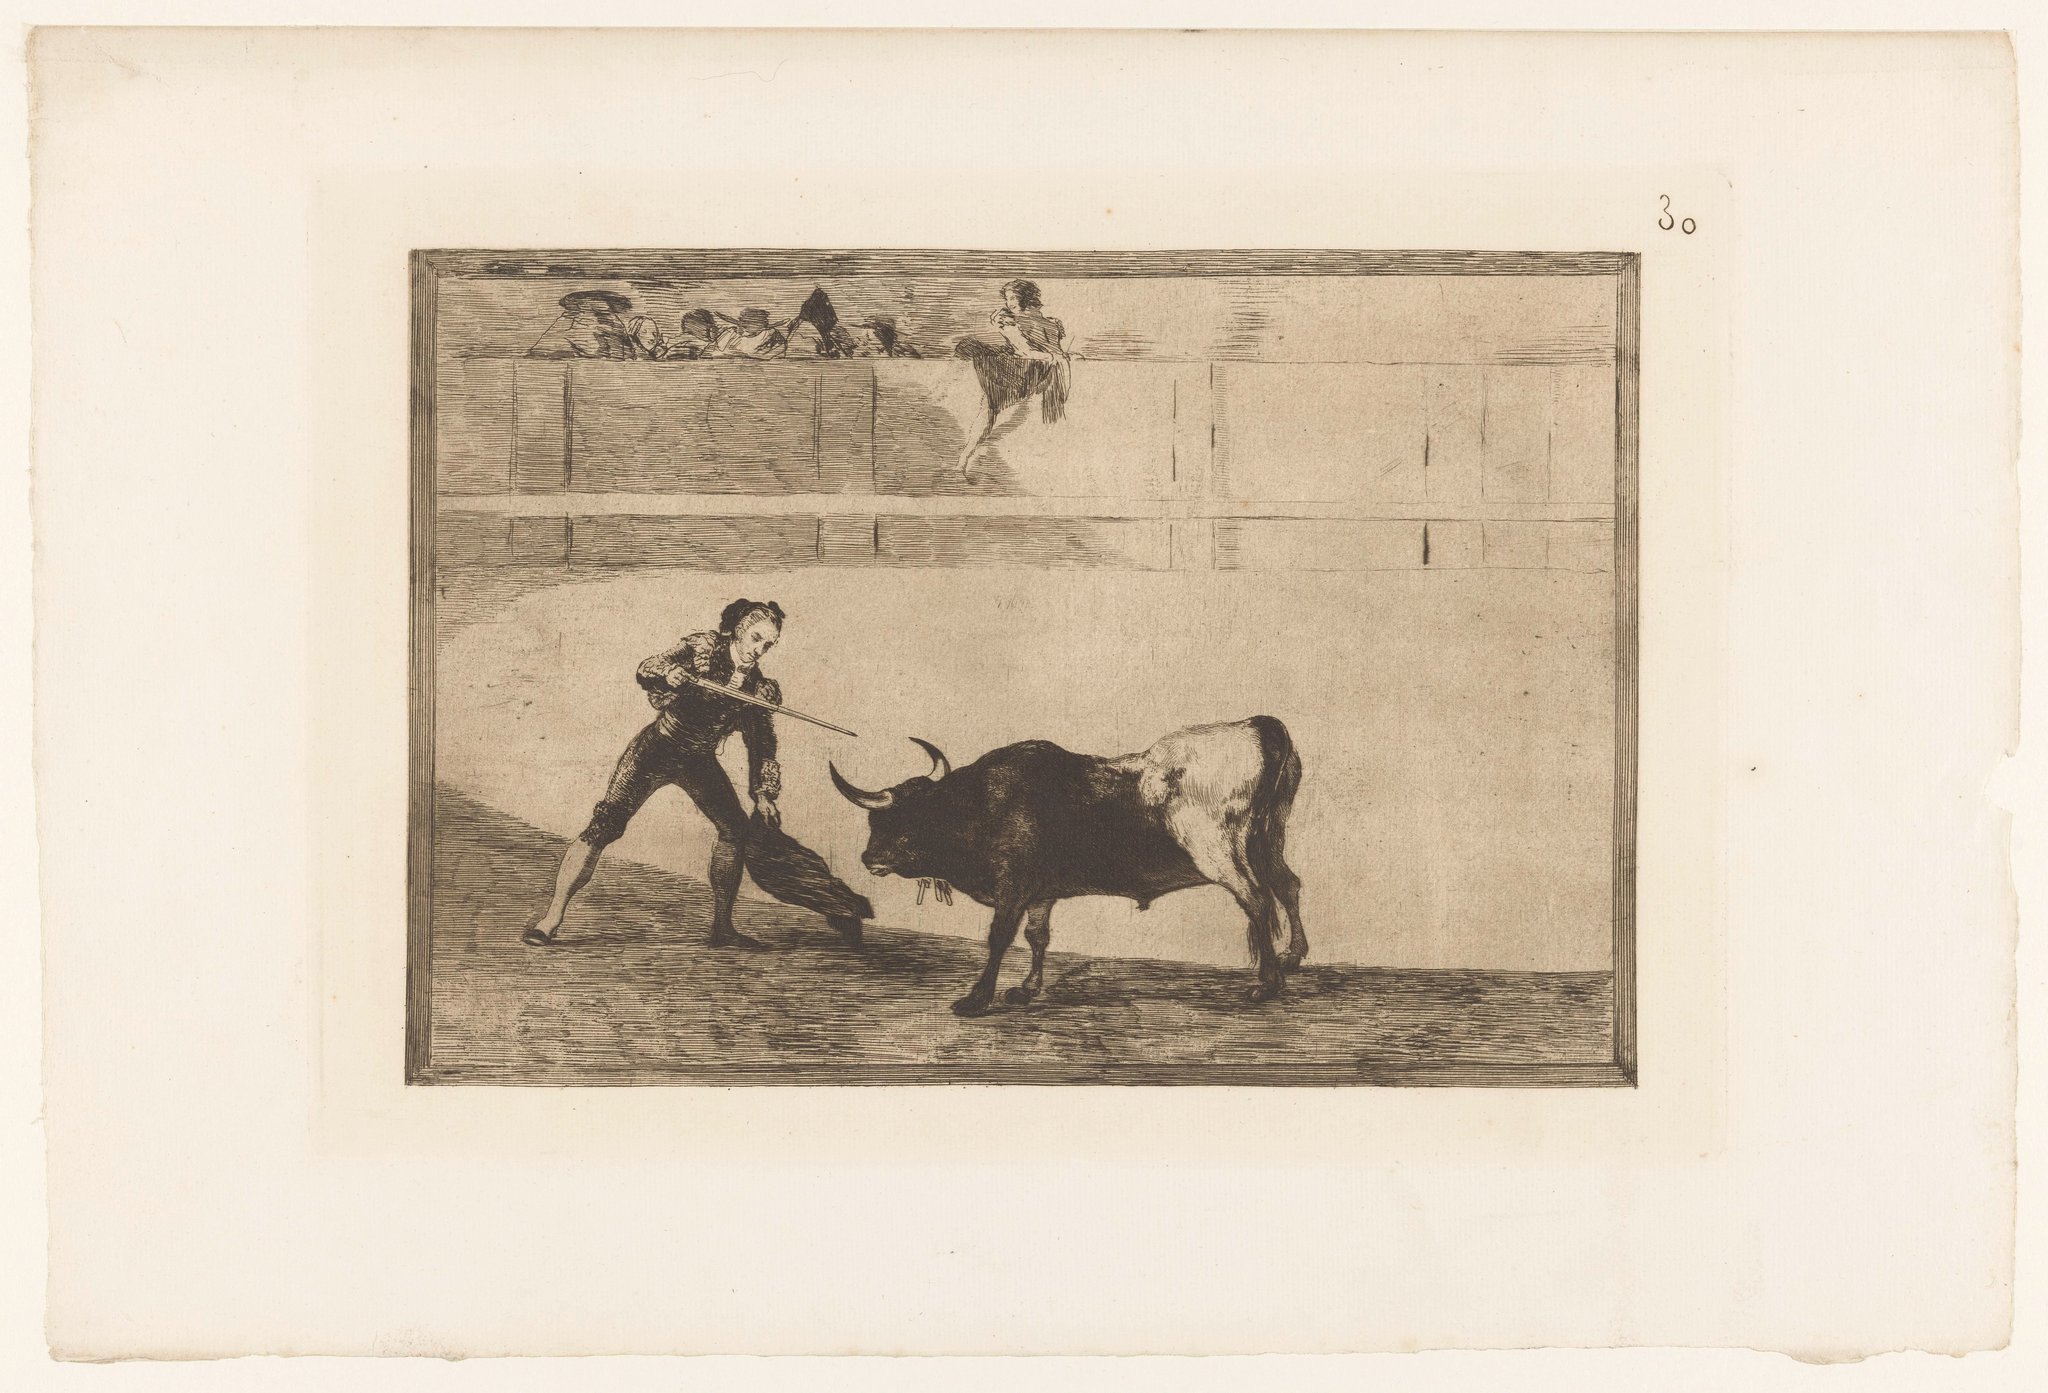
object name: print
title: Pedro Romero matando á toro parado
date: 1876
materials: paper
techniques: aquatint, etching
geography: spain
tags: bullfight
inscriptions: collector's mark: Lugt 2228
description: Deze prent maakt deel uit van een serie van 40 prenten door Francisco de Goya met voorstellingen van stierengevechten. De eerste editie bestond uit 33 genummerde prenten en werd uitgegeven in 1816. Dit betreft de derde editie, uitgegeven in 1876 door Eugène Loizelet en door hem voorzien van een titelprent en lijst met titels. Naast de 33 prenten publiceerde Loizelet ook de prenten die door Goya op de achterkanten van 7 van de platen werden geëtst. Deze zijn niet voorzien van nummers maar van de letters A-G.